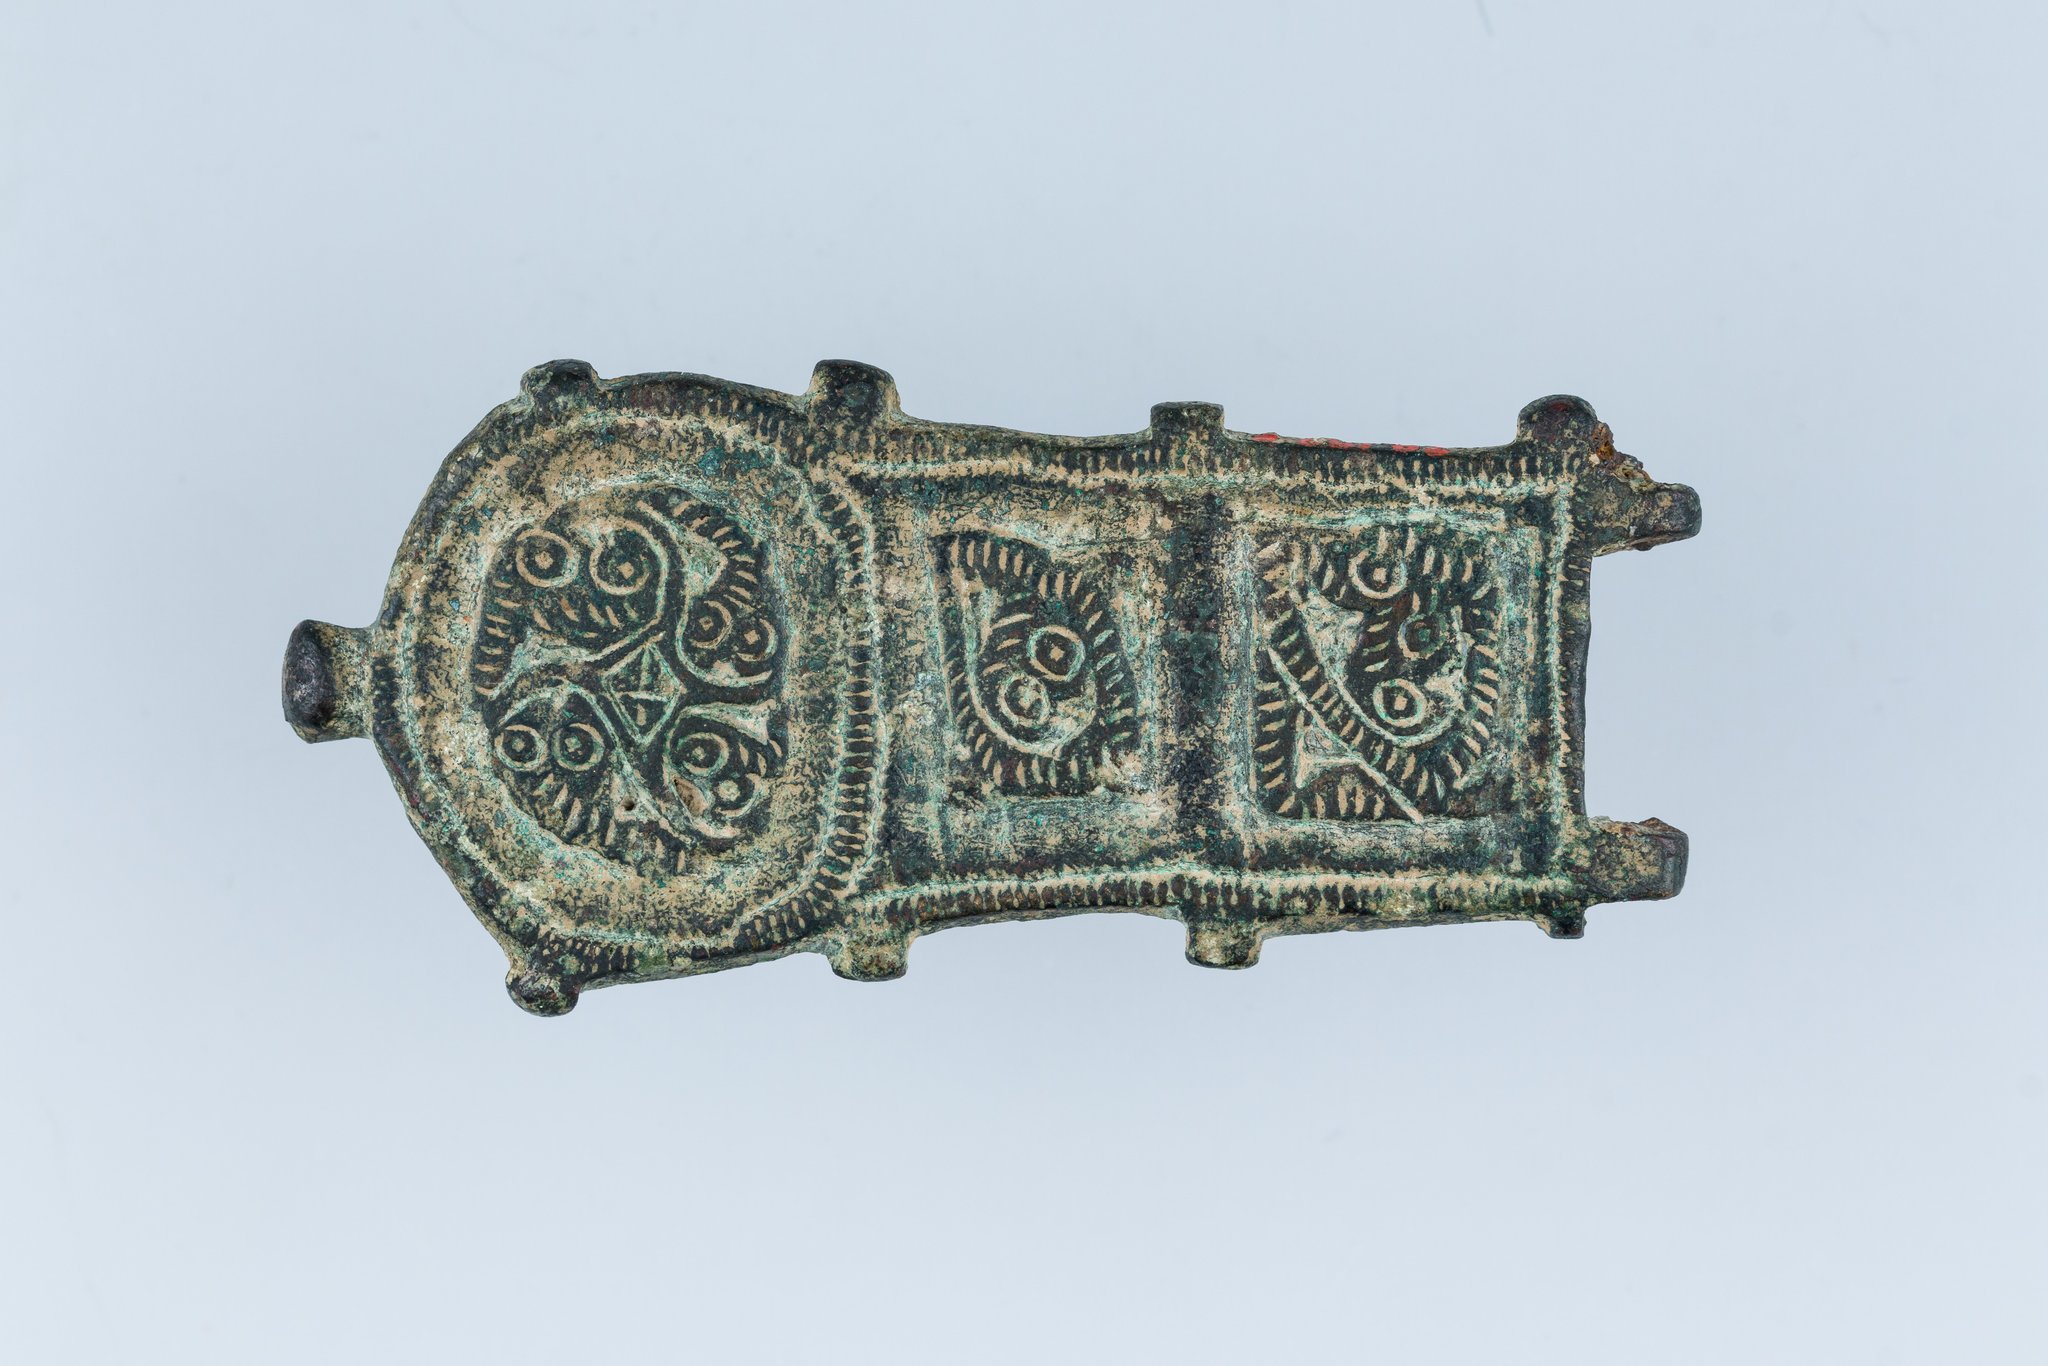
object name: buckle shank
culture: visigothic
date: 601-700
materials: copper alloy, tin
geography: spain or portugal